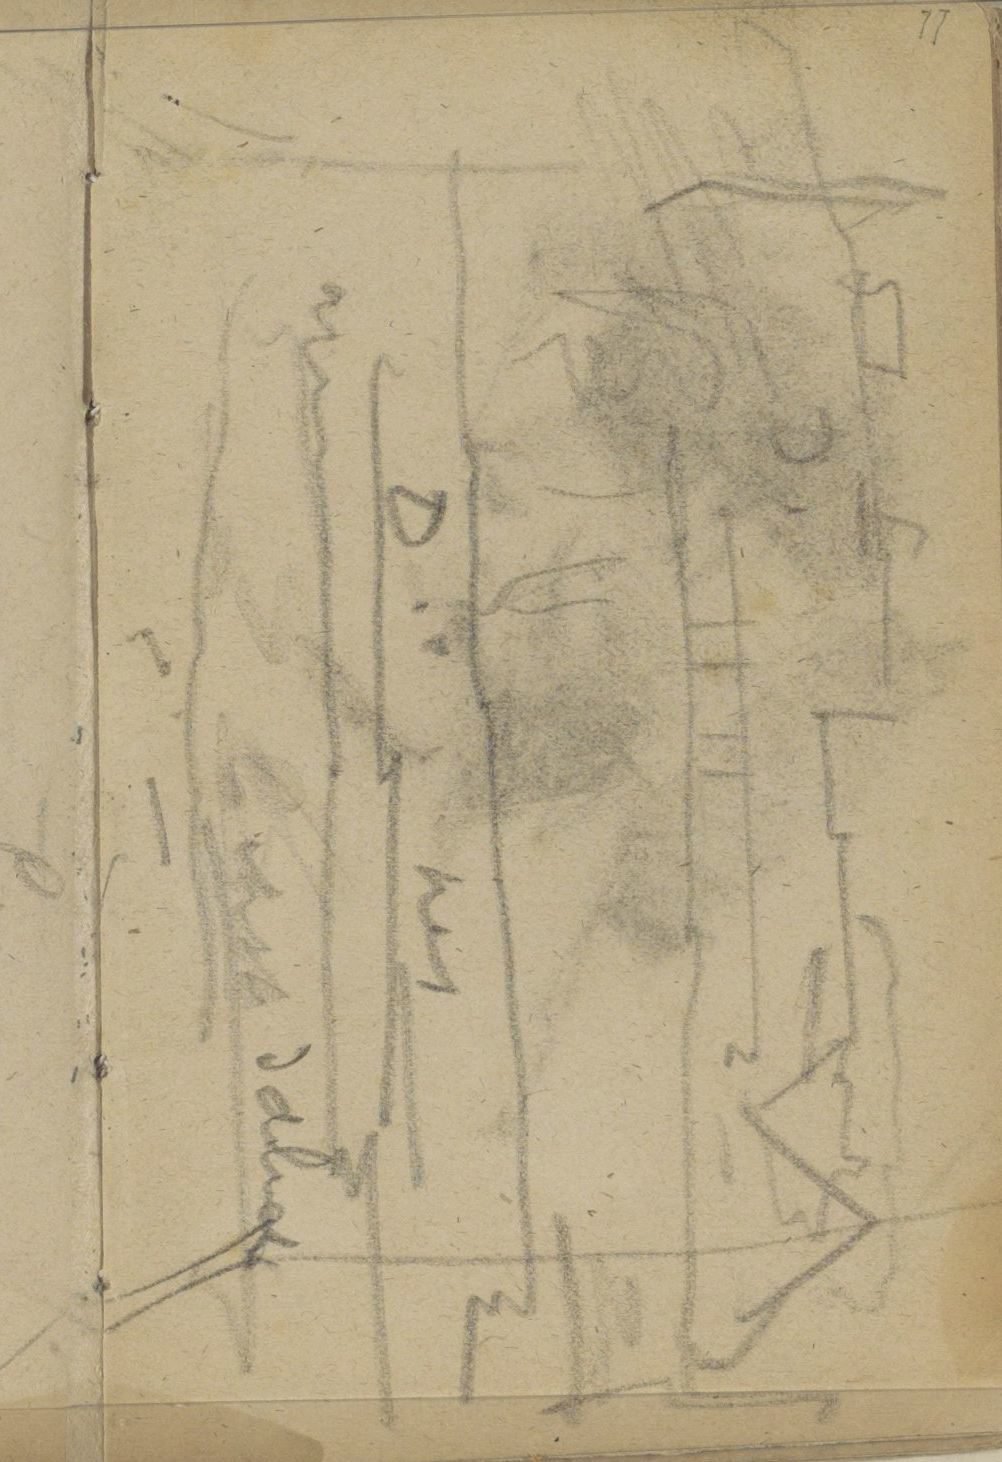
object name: sketchbook leaf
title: Gezicht op gebouwen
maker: george hendrik breitner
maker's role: draughtsman, painter, print maker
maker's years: 1857-1923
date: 1881-1883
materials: paper, pencil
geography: south holland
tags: civic architecture; edifices; dwellings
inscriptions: annotation: ‘[...]/ Nes[?]/ [...]’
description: Gezicht op gebouwen. Pagina 77 uit een schetsboek met 70 bladen.